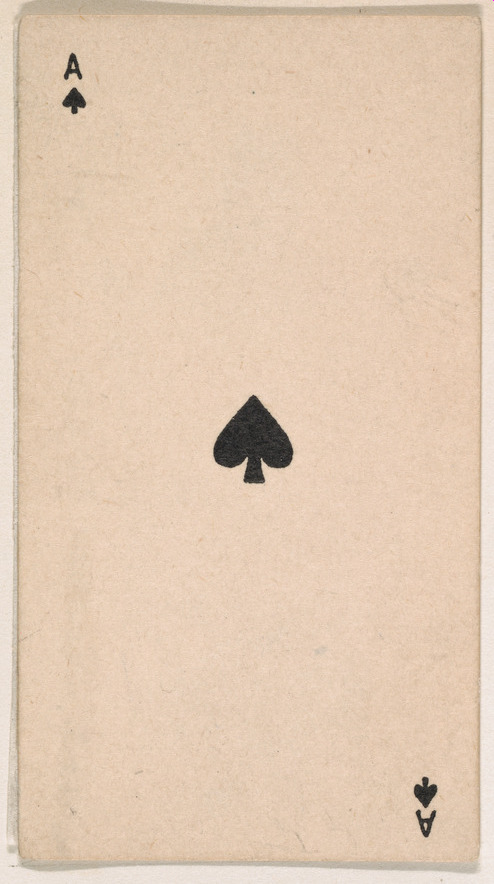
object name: print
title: Ace of Spades, from the Transparent Playing Cards series (N220) issued by Kinney Bros.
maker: kinney brothers tobacco company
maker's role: publisher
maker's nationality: american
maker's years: 1869-2011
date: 1888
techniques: color lithograph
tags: playing cards